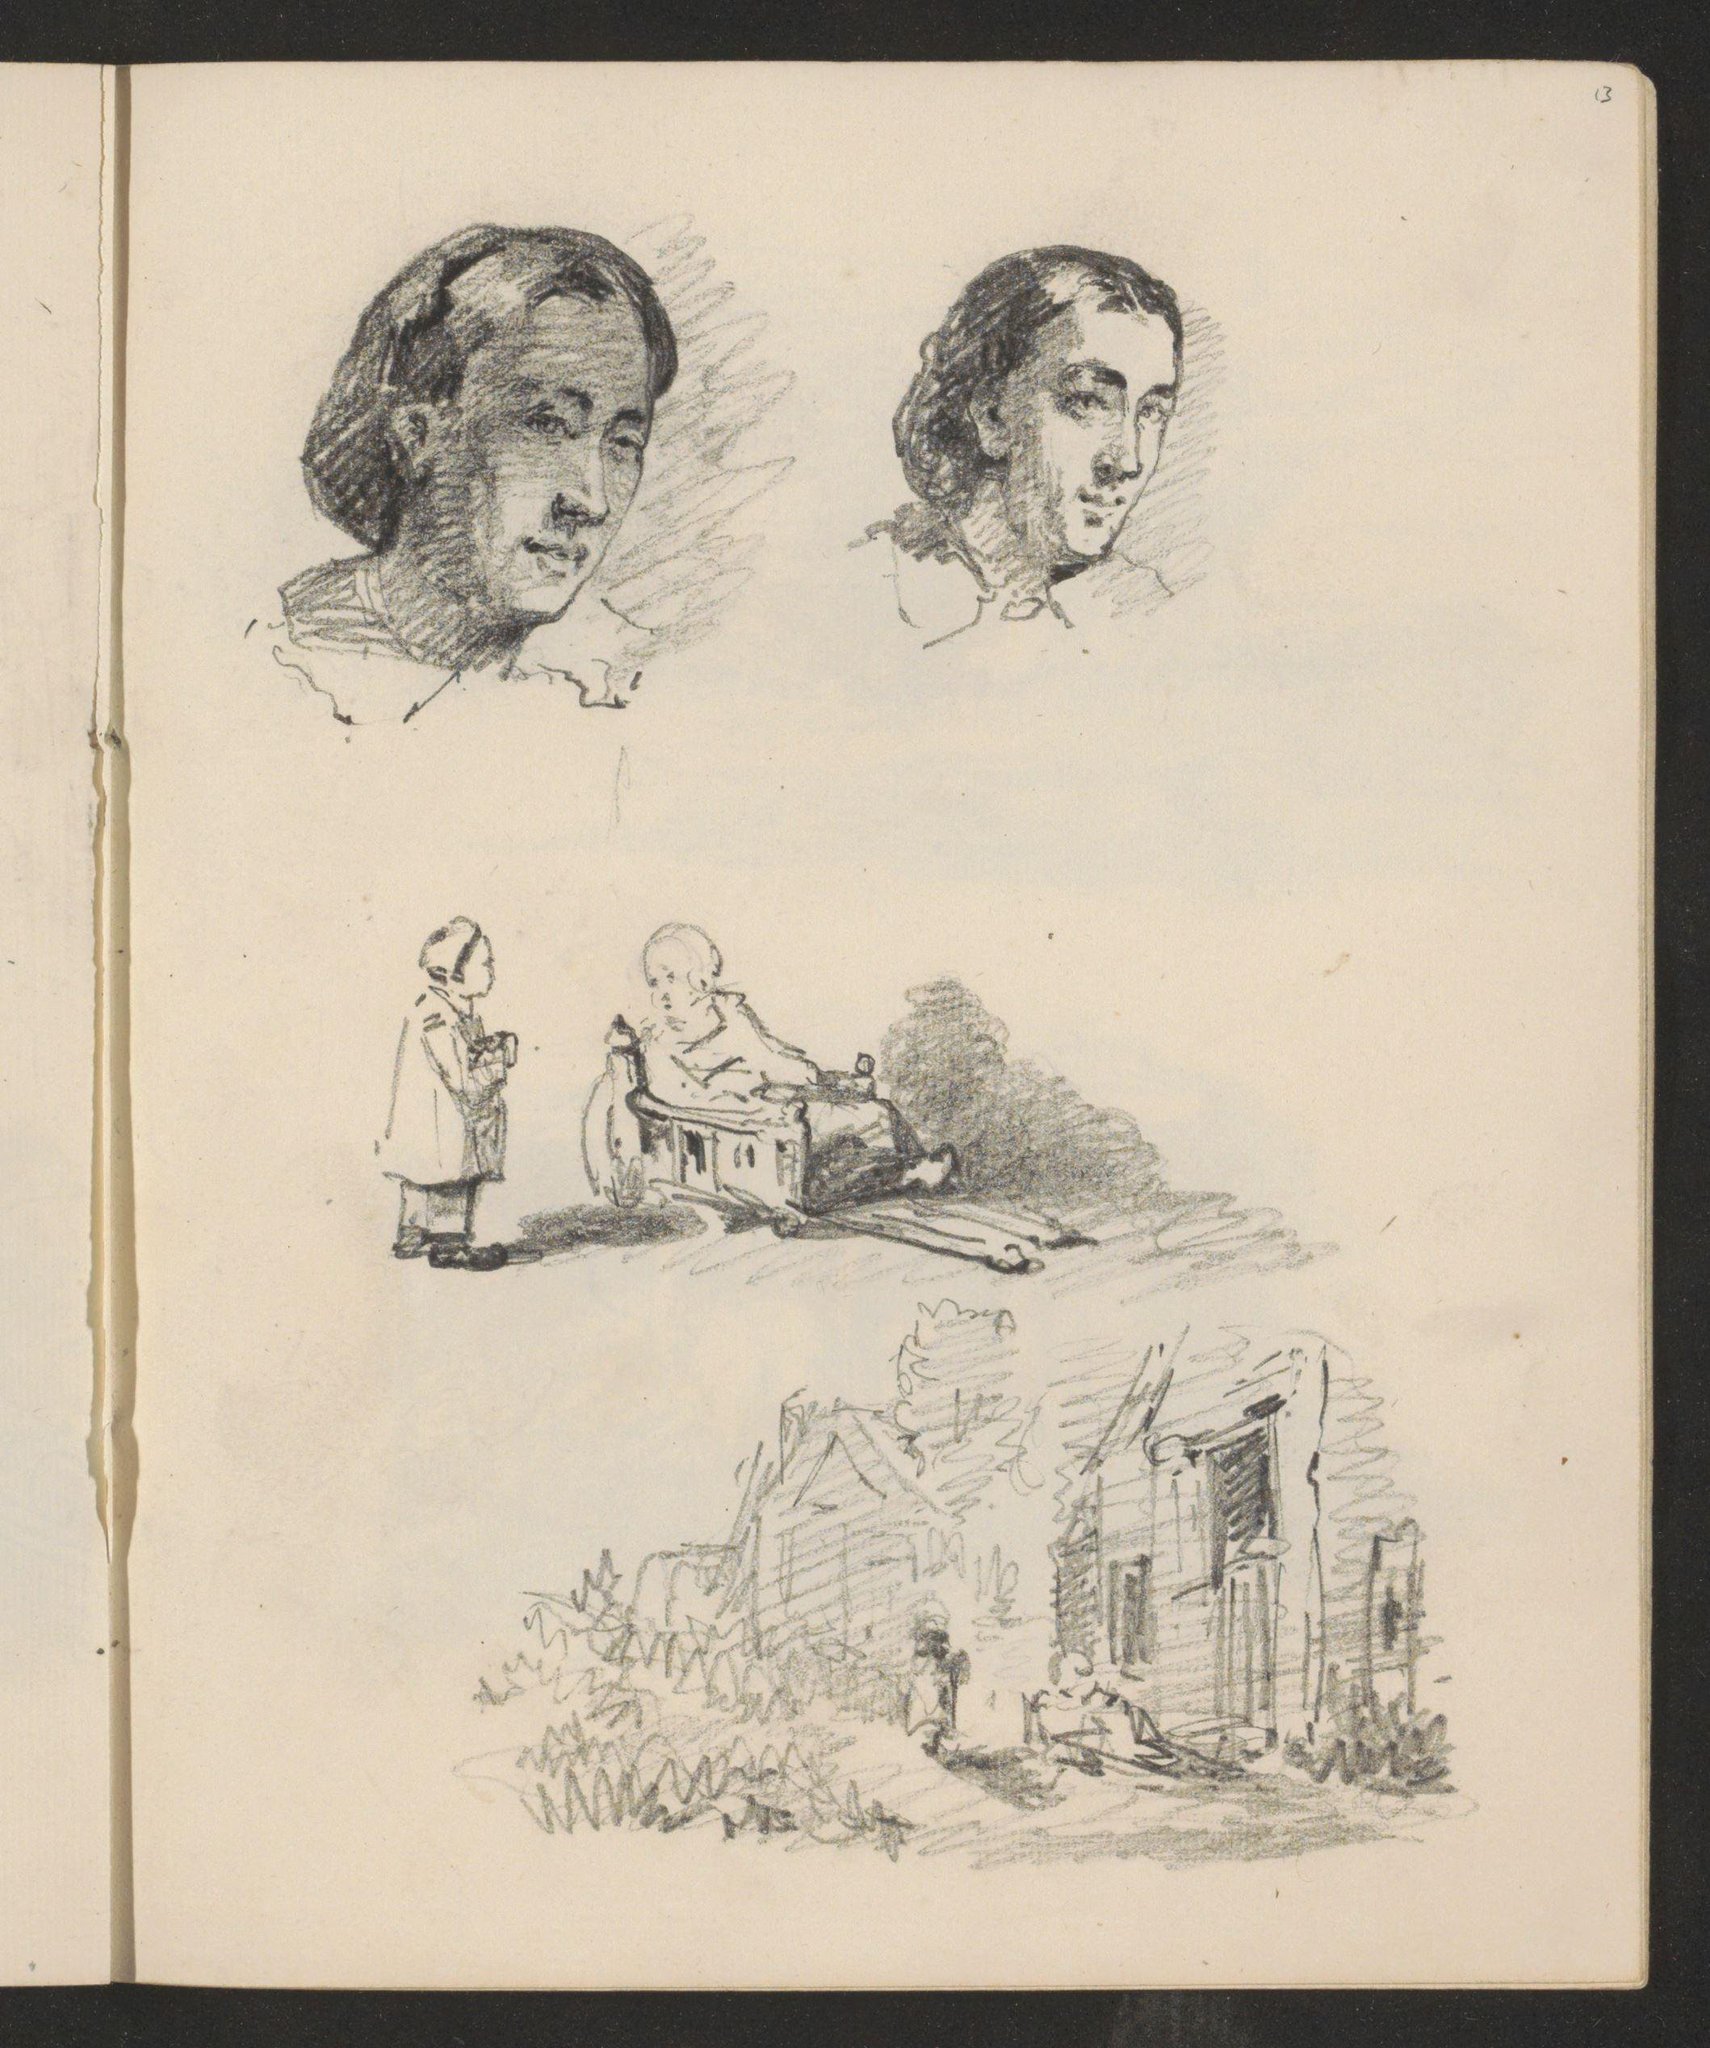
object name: sketchbook leaf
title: Portretkoppen, spelende kinderen en figuren voor enkele huizen op het platteland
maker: maria vos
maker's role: draughtsman, painter, print maker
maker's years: 1824-1906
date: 1858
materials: paper, pencil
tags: head (human), toddler, rural housing, e.g. country-house, villa, cottage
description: Blad 13 recto uit een schetsboek met 19 bladen.